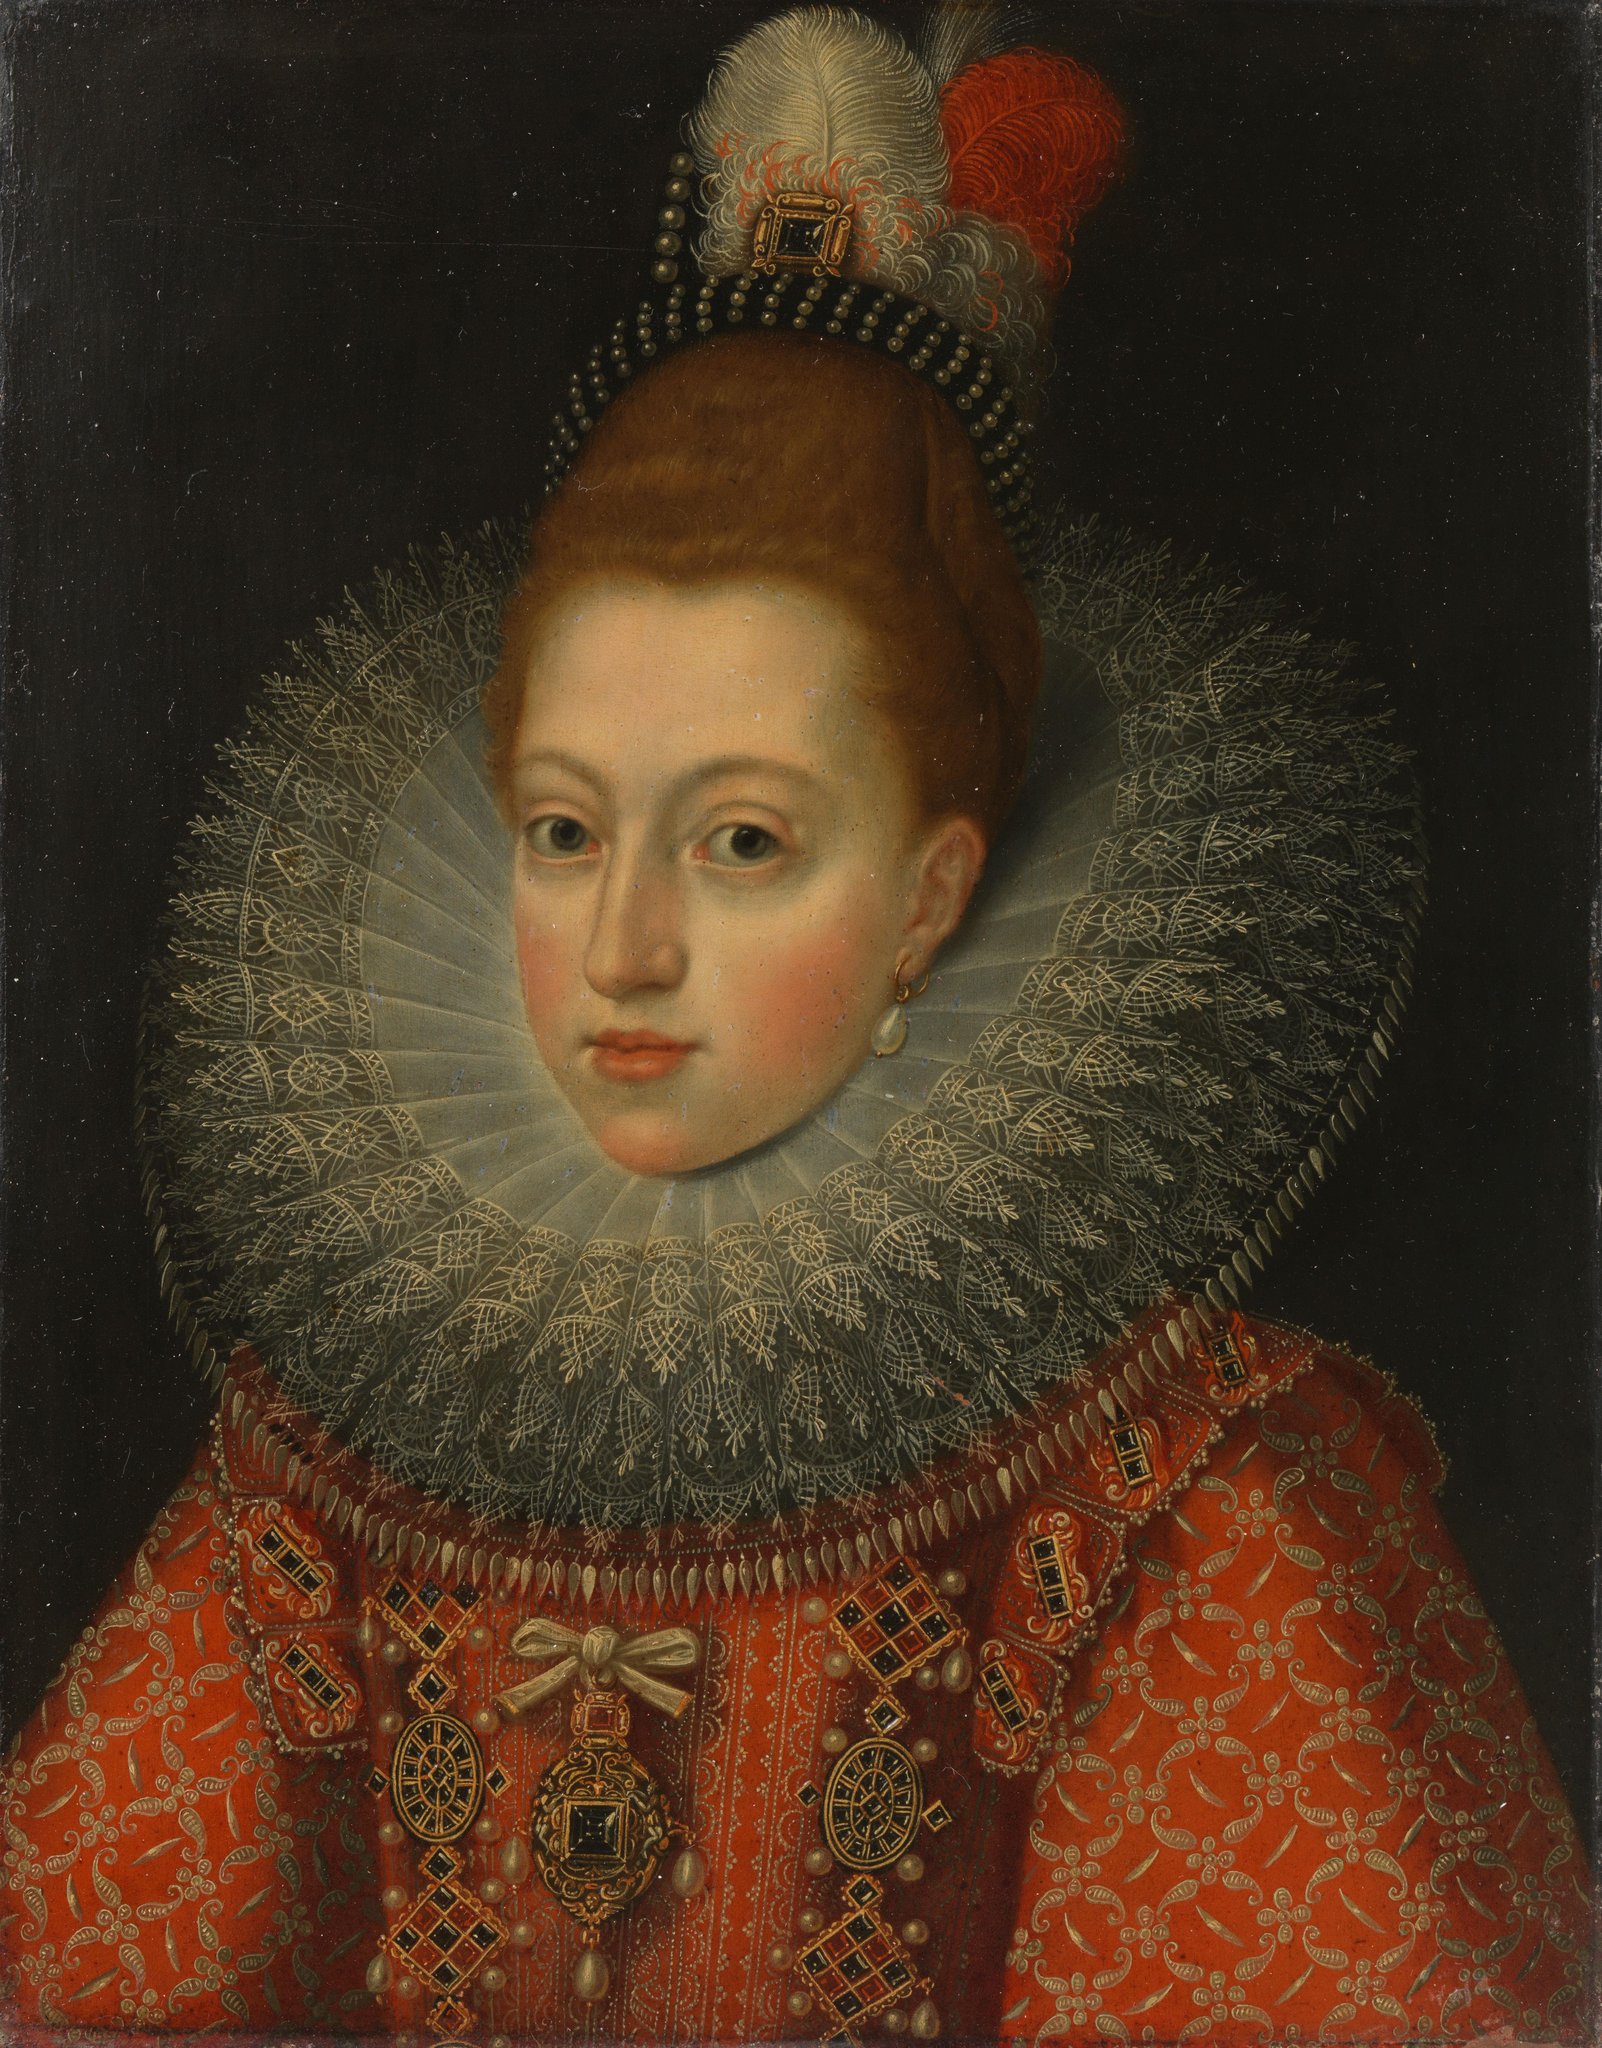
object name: painting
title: Portrait of Margaret of Austria (1584-1611), Queen of Spain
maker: Anonymous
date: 1600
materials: copper, oil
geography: southern netherlands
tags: margaretha van oostenrijk (koningin van spanje), historical persons - bb - woman, queen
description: Portret van Margaretha van Oostenrijk (1584-1611), echtgenote van Filips III. Buste naar links. Pendant van SK-A-507.